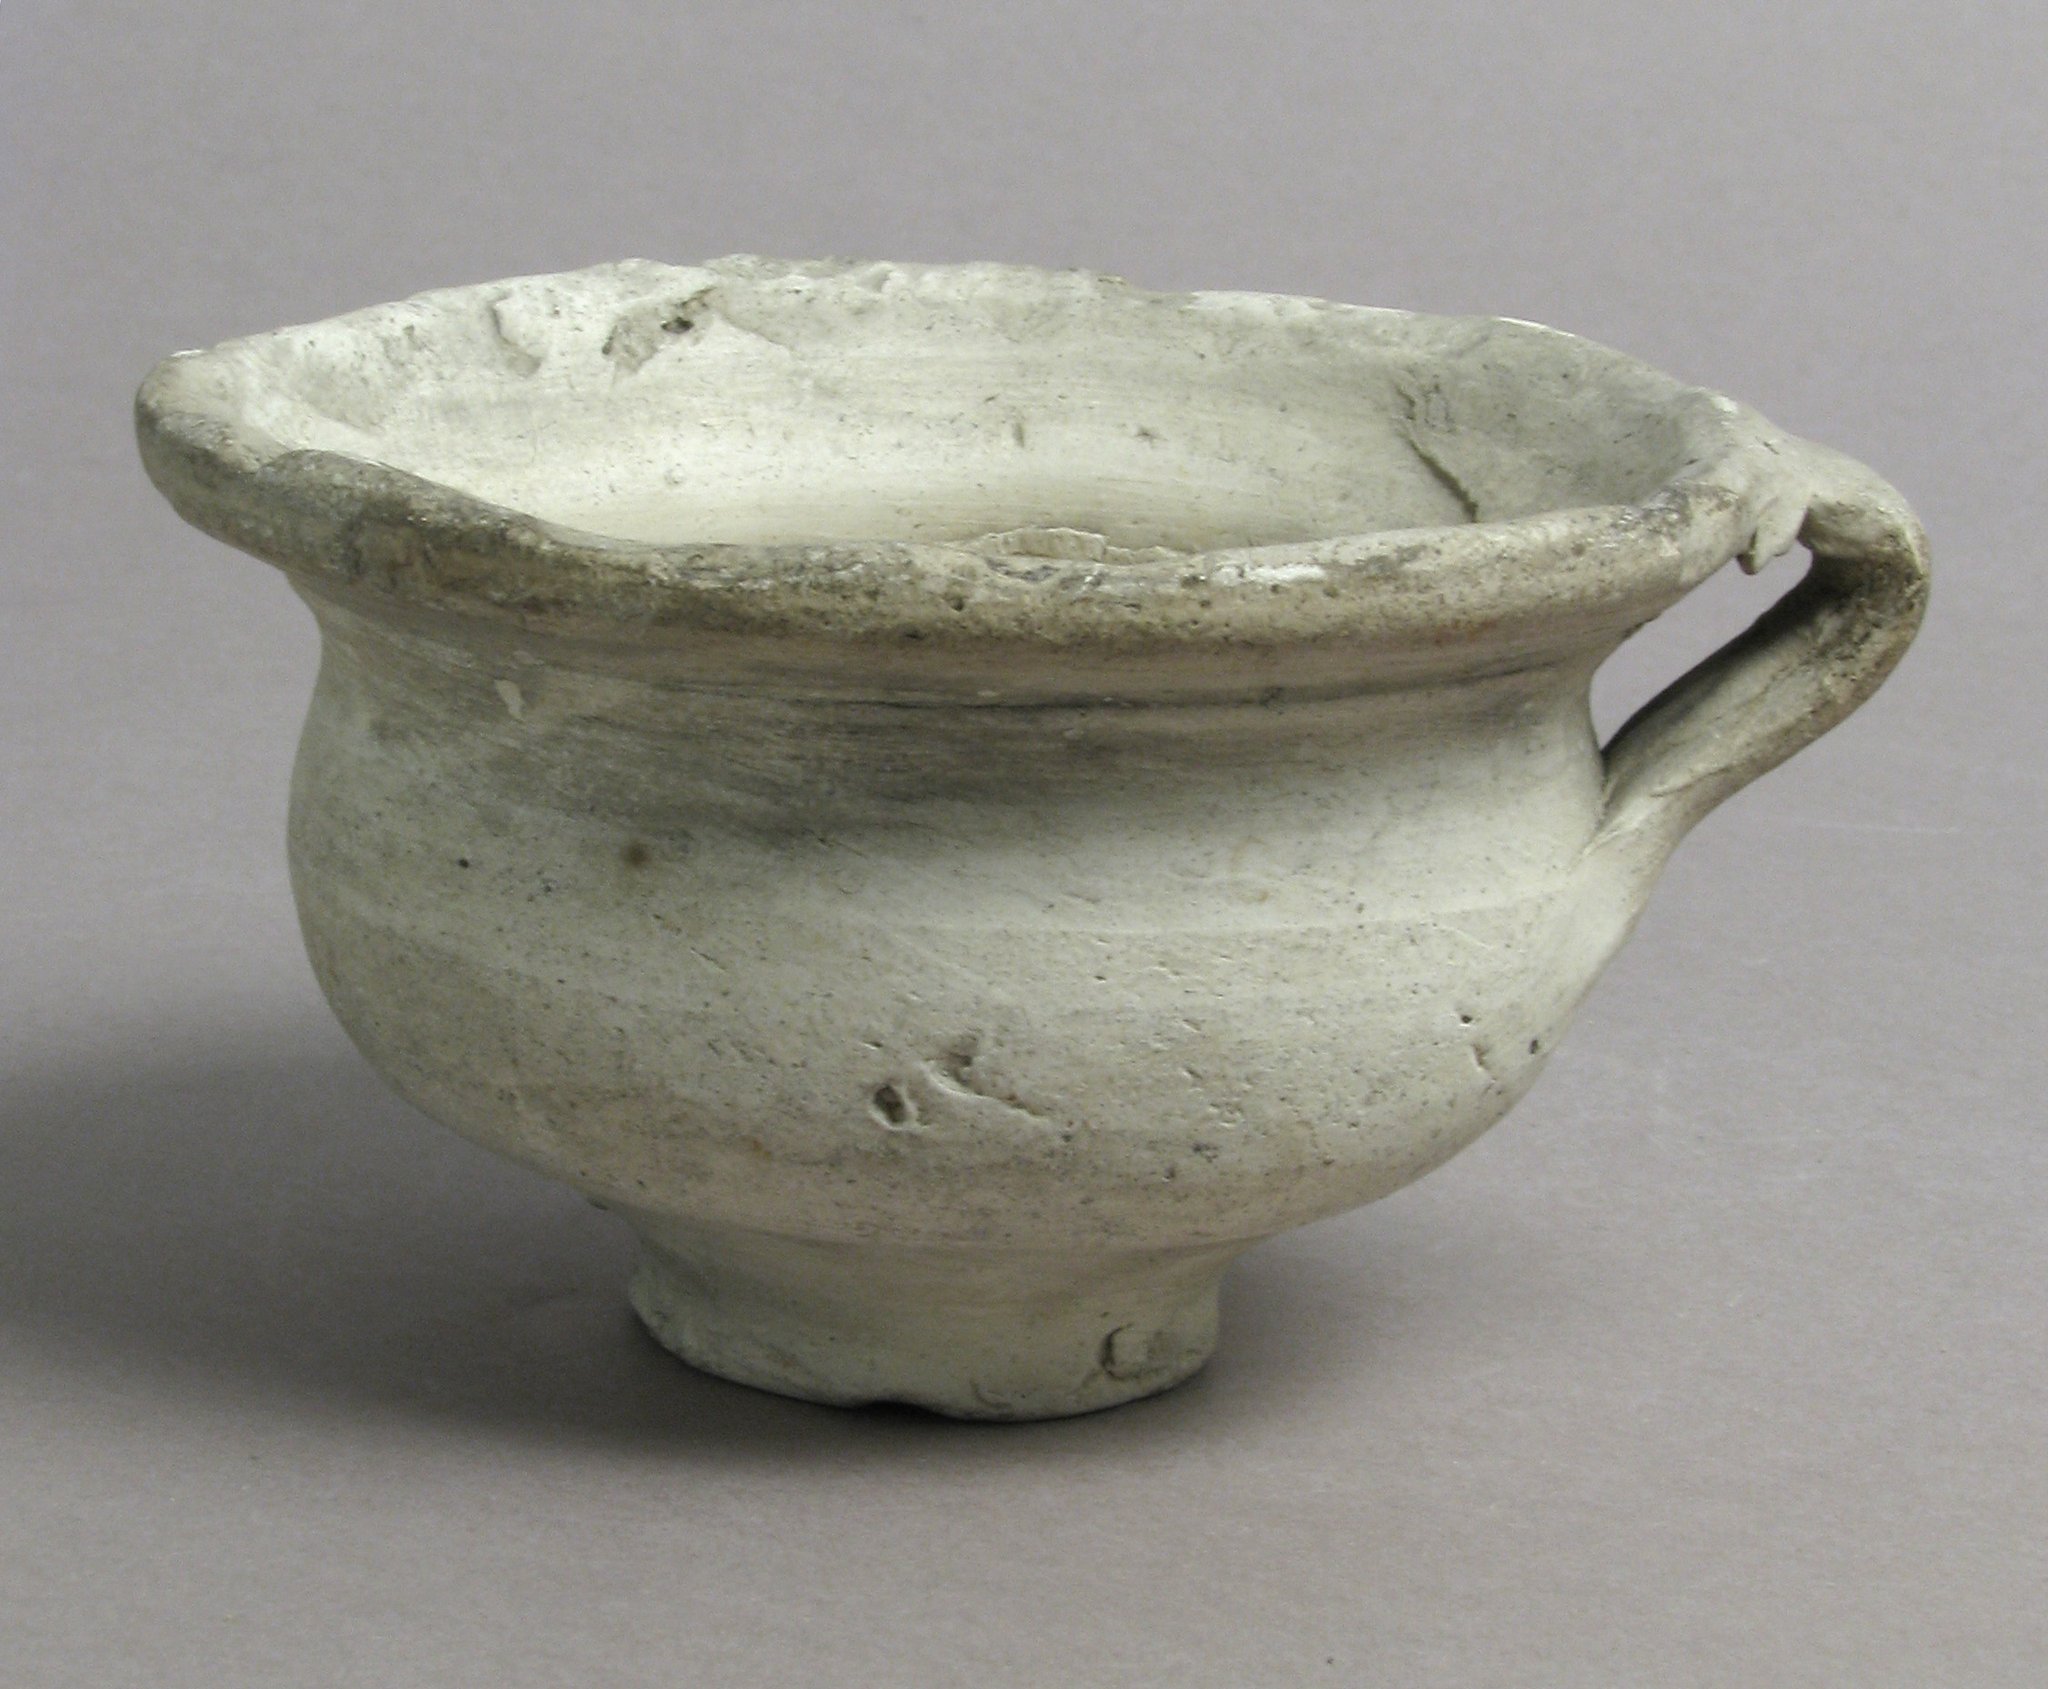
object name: cup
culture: french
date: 1401-1500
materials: earthenware